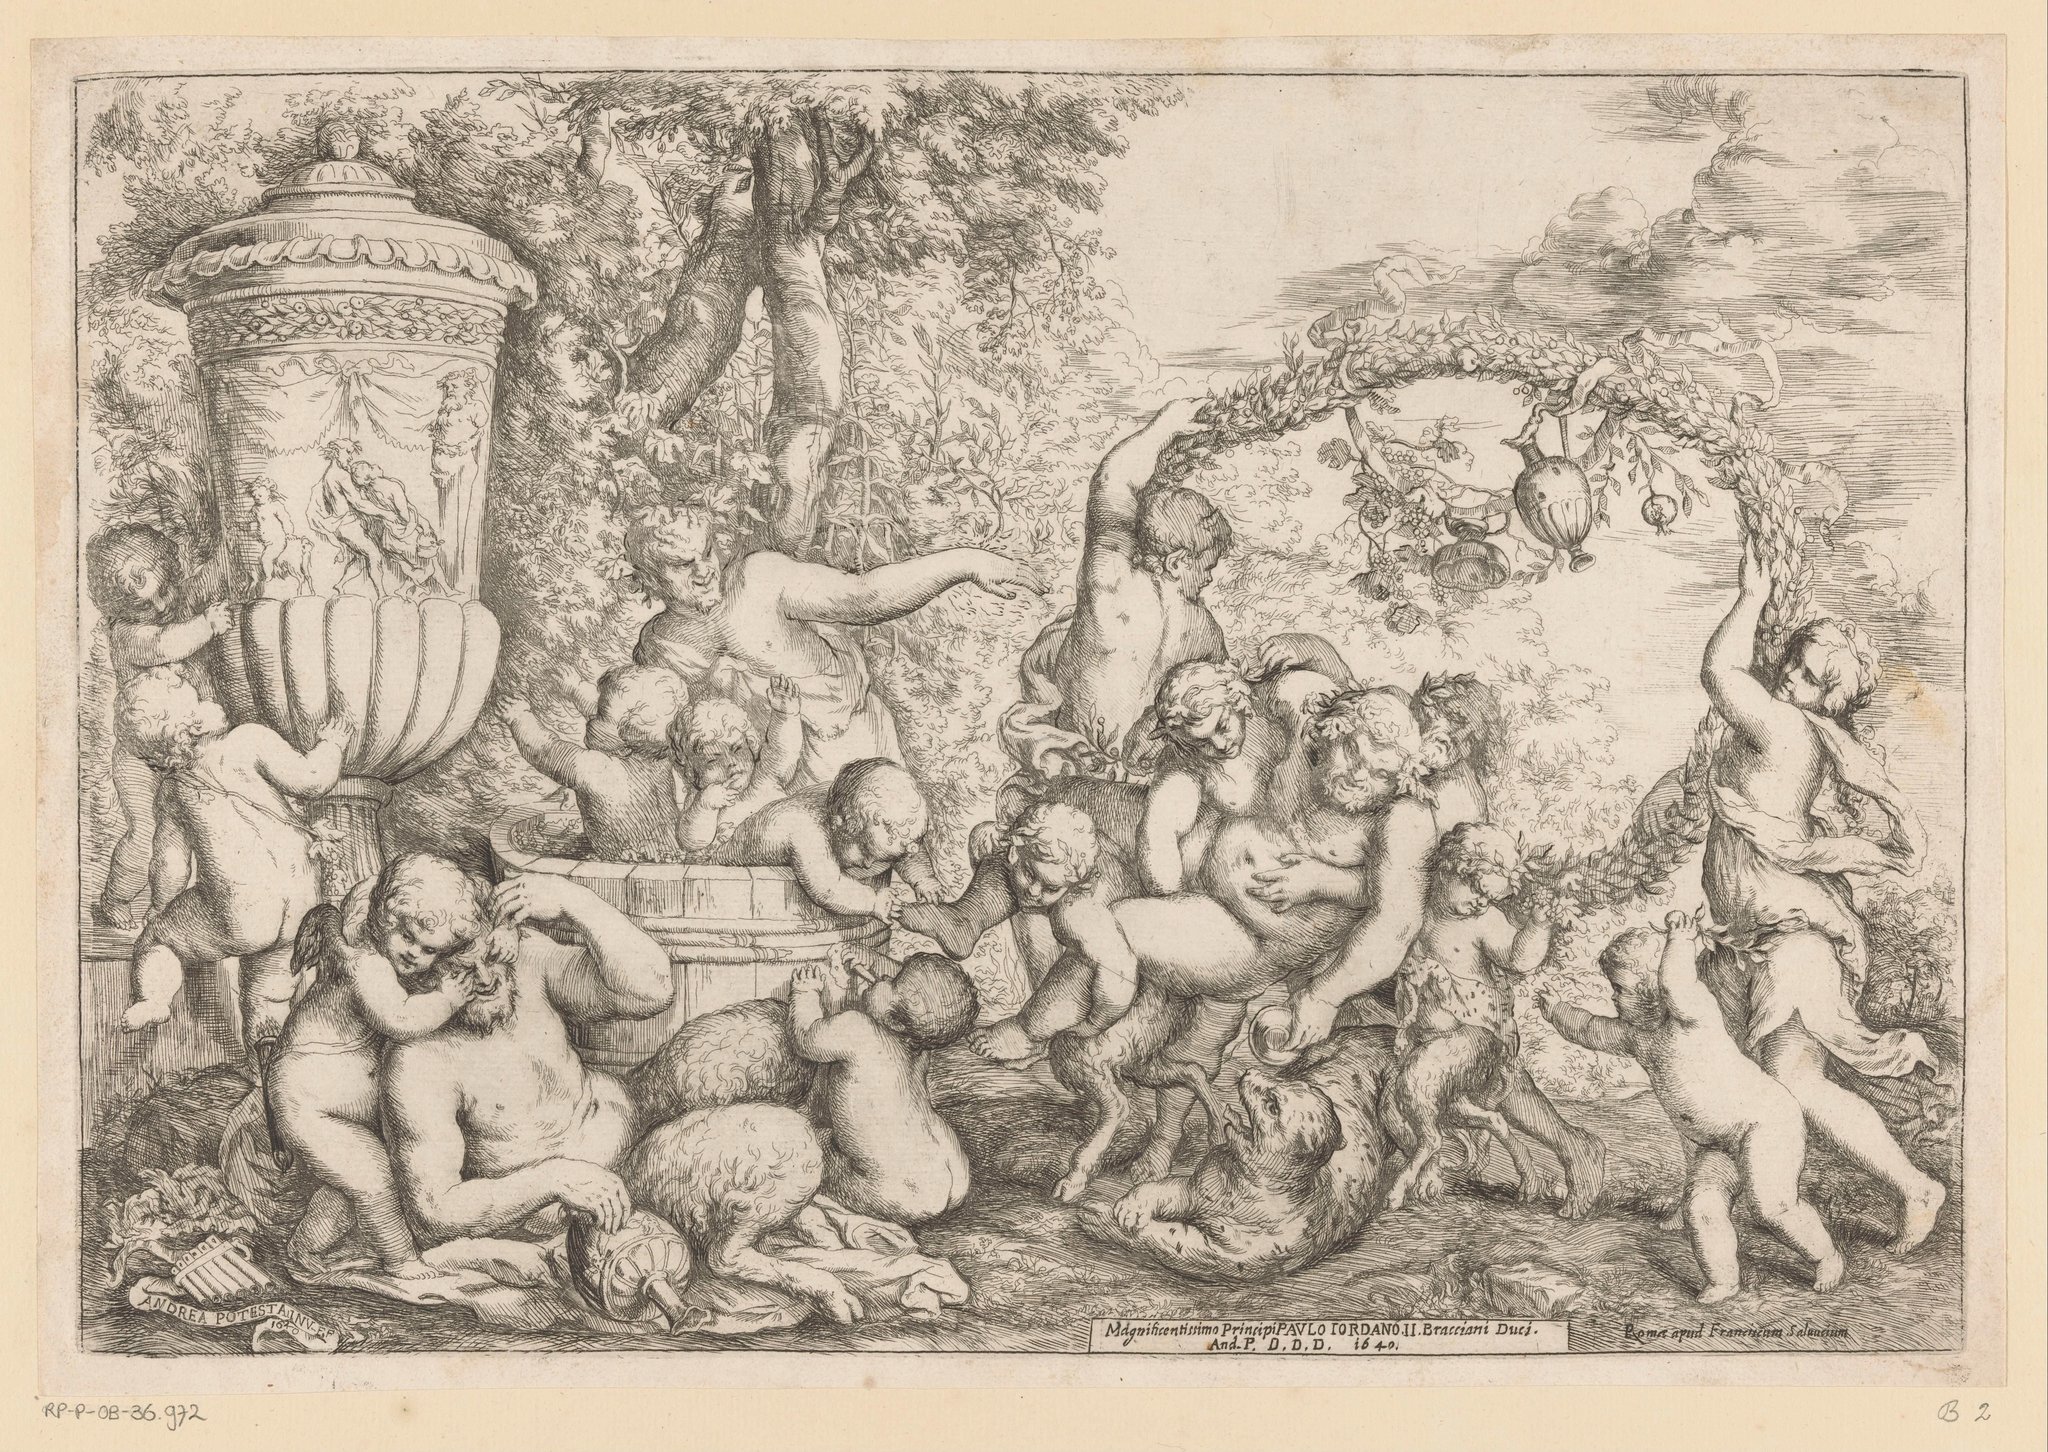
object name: print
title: Bacchanaal met Silenus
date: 1640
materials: paper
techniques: etching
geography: italy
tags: children's bacchanal, maenad(s), female bacchant(es), (story of) silenus, satyr(s) (in general), drunkenness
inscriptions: collector's mark: Lugt 240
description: Een bacchanaal in een landschap met saters, kinderen, bacchanten en de dronken Silenus. Links een grote antieke vaas.